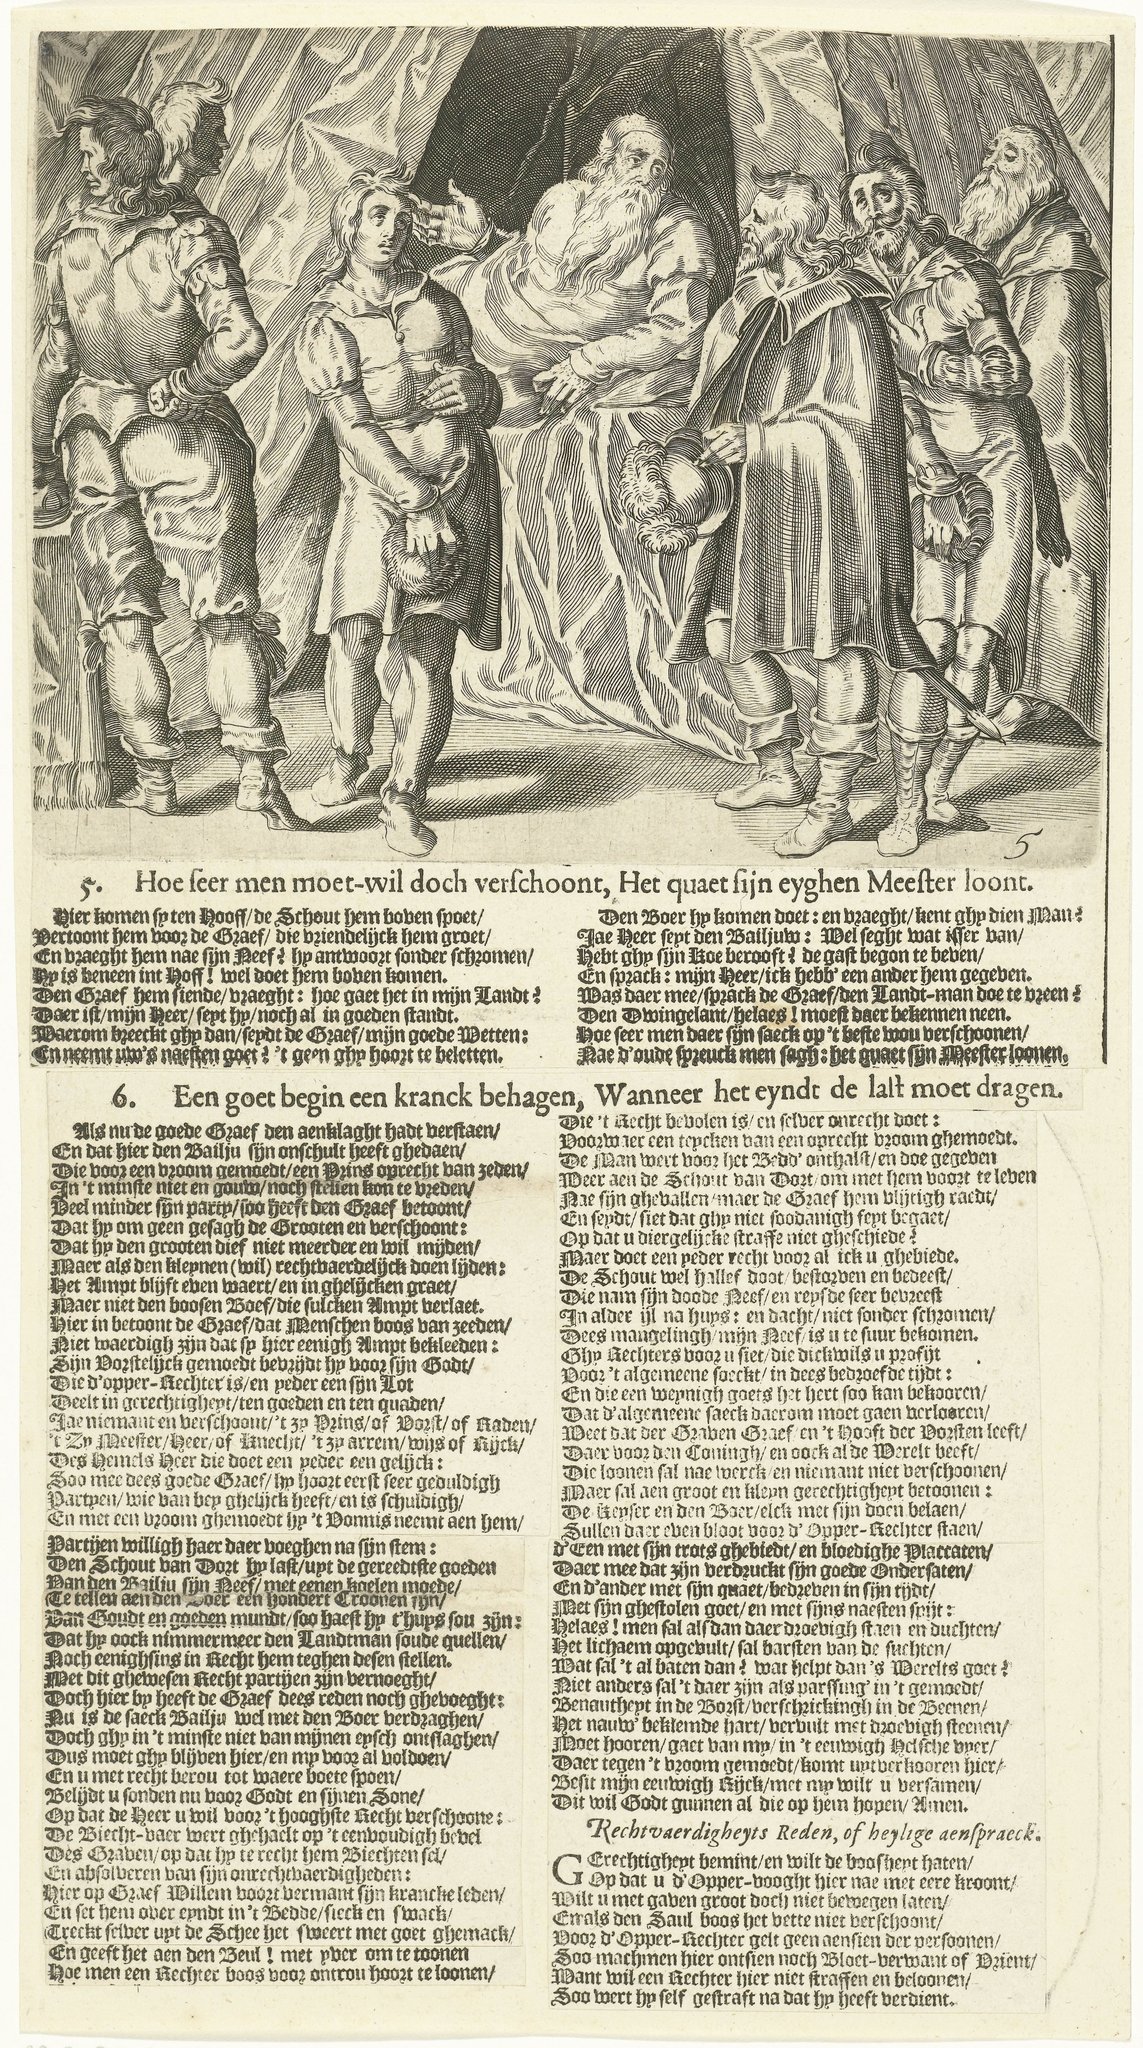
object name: print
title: 5. Hoe seer men moet-wil doch verschoont, Het quaet sijn eyghen Meester Loont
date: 1613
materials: paper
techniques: engraving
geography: leiden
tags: willem iii de goede (graaf van holland en henegouwen), netherlands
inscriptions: collector's mark: Lugt 240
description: Graaf Willem III hoort liggend in bed de verhalen aan van de boer, links, en de baljuw van Zuid-Holland, rechts staande naast de schout van Dordrecht. Aan het hof Valenciennes. Voorstelling nr. 5 in een serie van zes kleine scènes van de opeenvolgende episoden van het verhaal van de Rechtspraak van graaf Willem III in het jaar 1336. Deze kleine prenten behoren aan weerszijden van de grote centrale voorstelling. Bij elke voorstelling een onderschrift bestaande uit een spreuk en een vers van twee kolommen van acht regels. Bij deze voorstelling is ook het onderschrift en de tekst van de centrale voorstelling gevoegd.